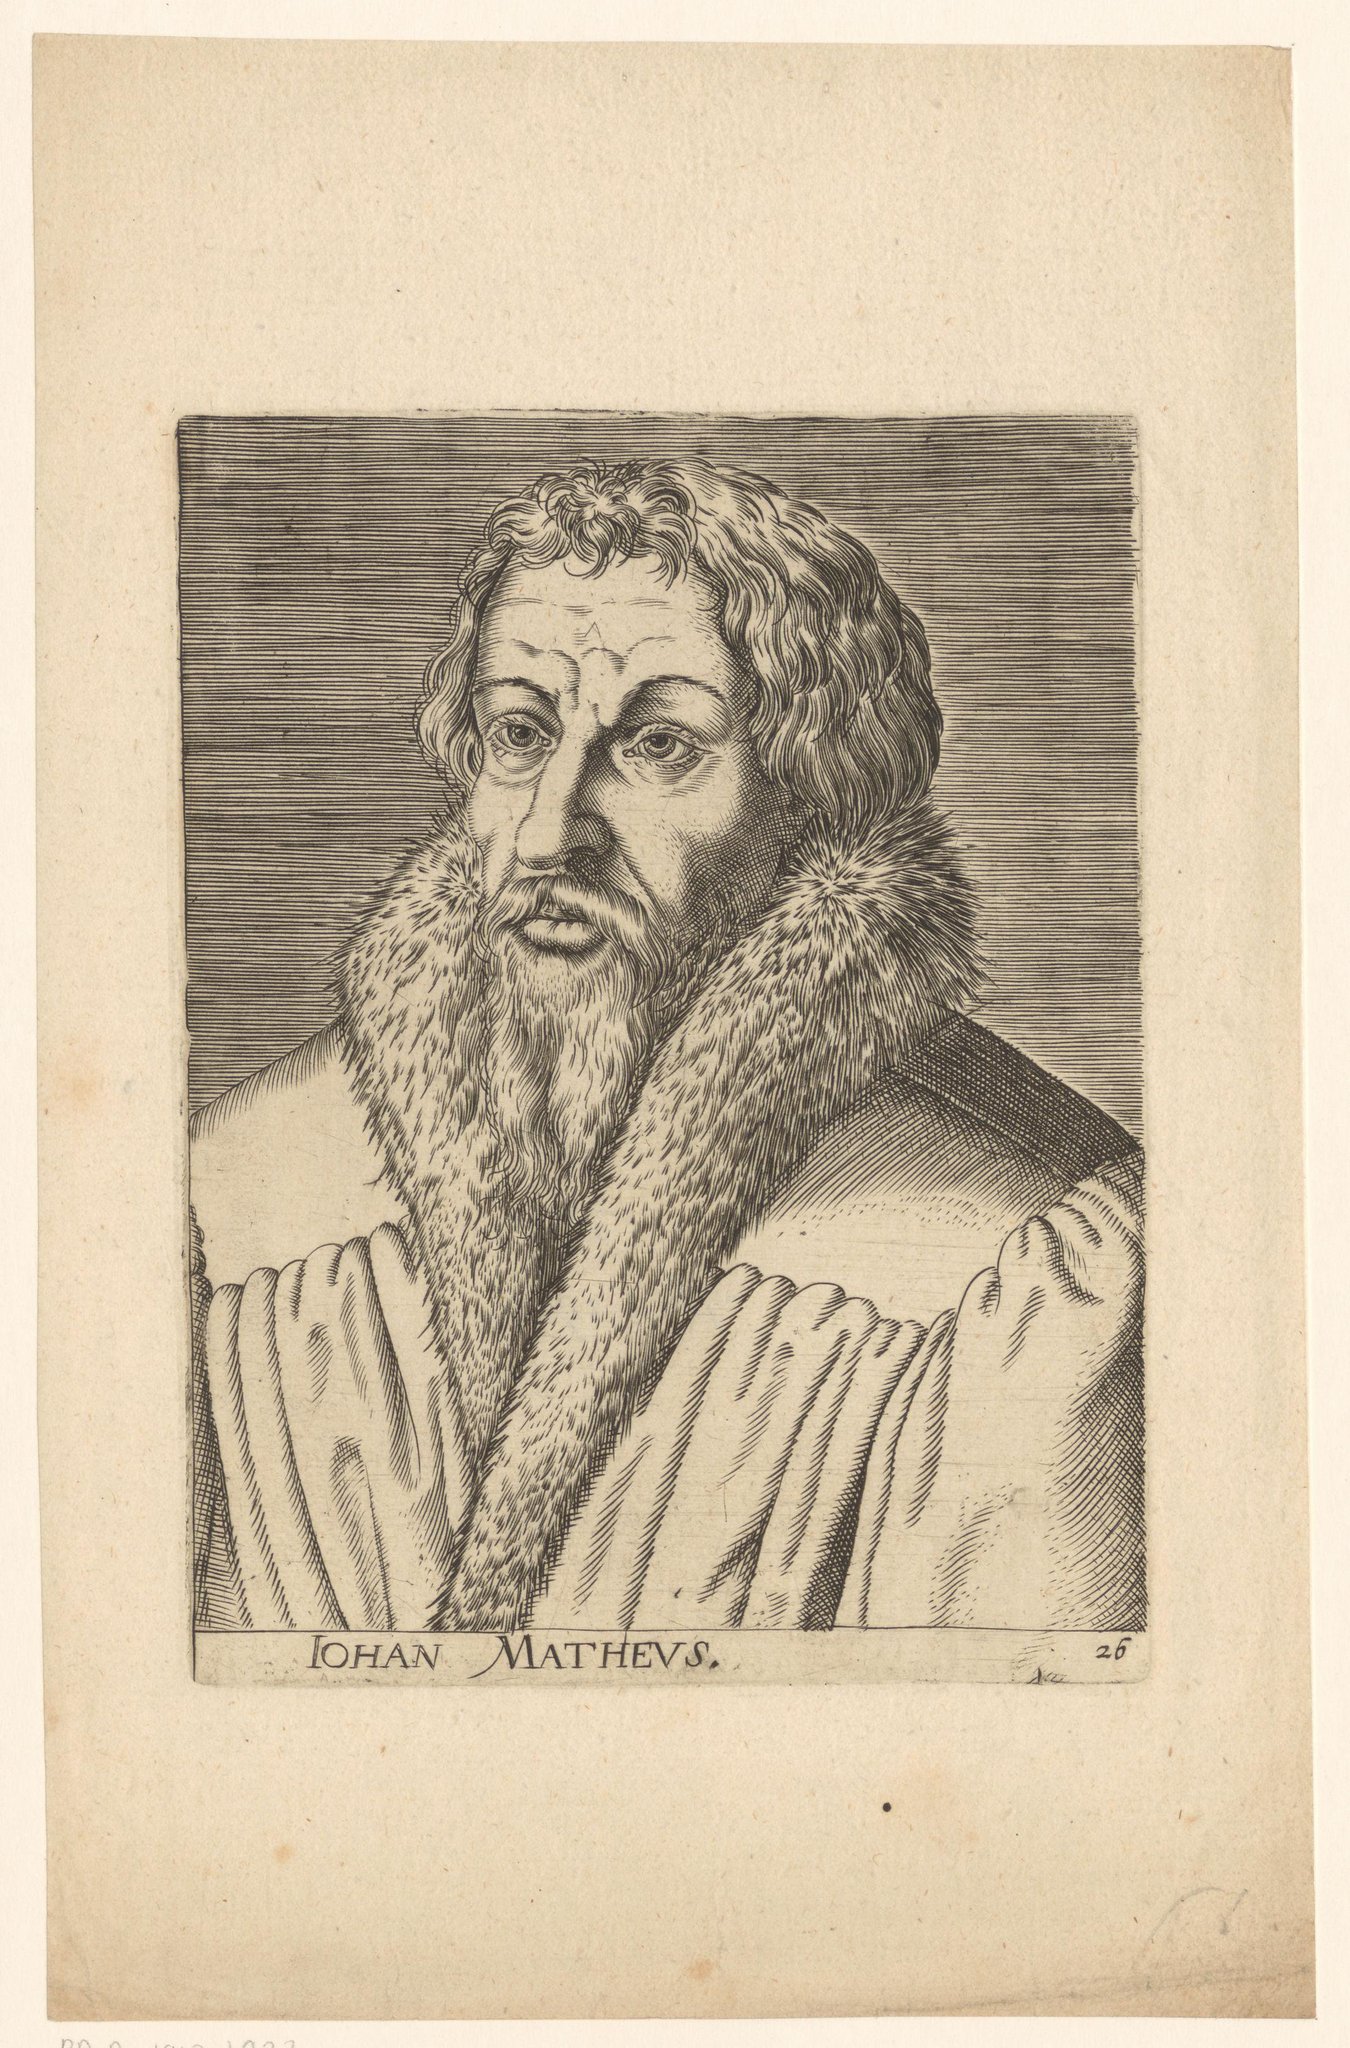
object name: print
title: Portret van Johannes Mathesius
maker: Anonymous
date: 1563-1642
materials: paper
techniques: etching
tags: theologian, historical persons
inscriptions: collector's mark: Lugt 2228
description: Deze prent (een impressie) hoort bij een serie portretten van sturende personen tijdens de reformatie.